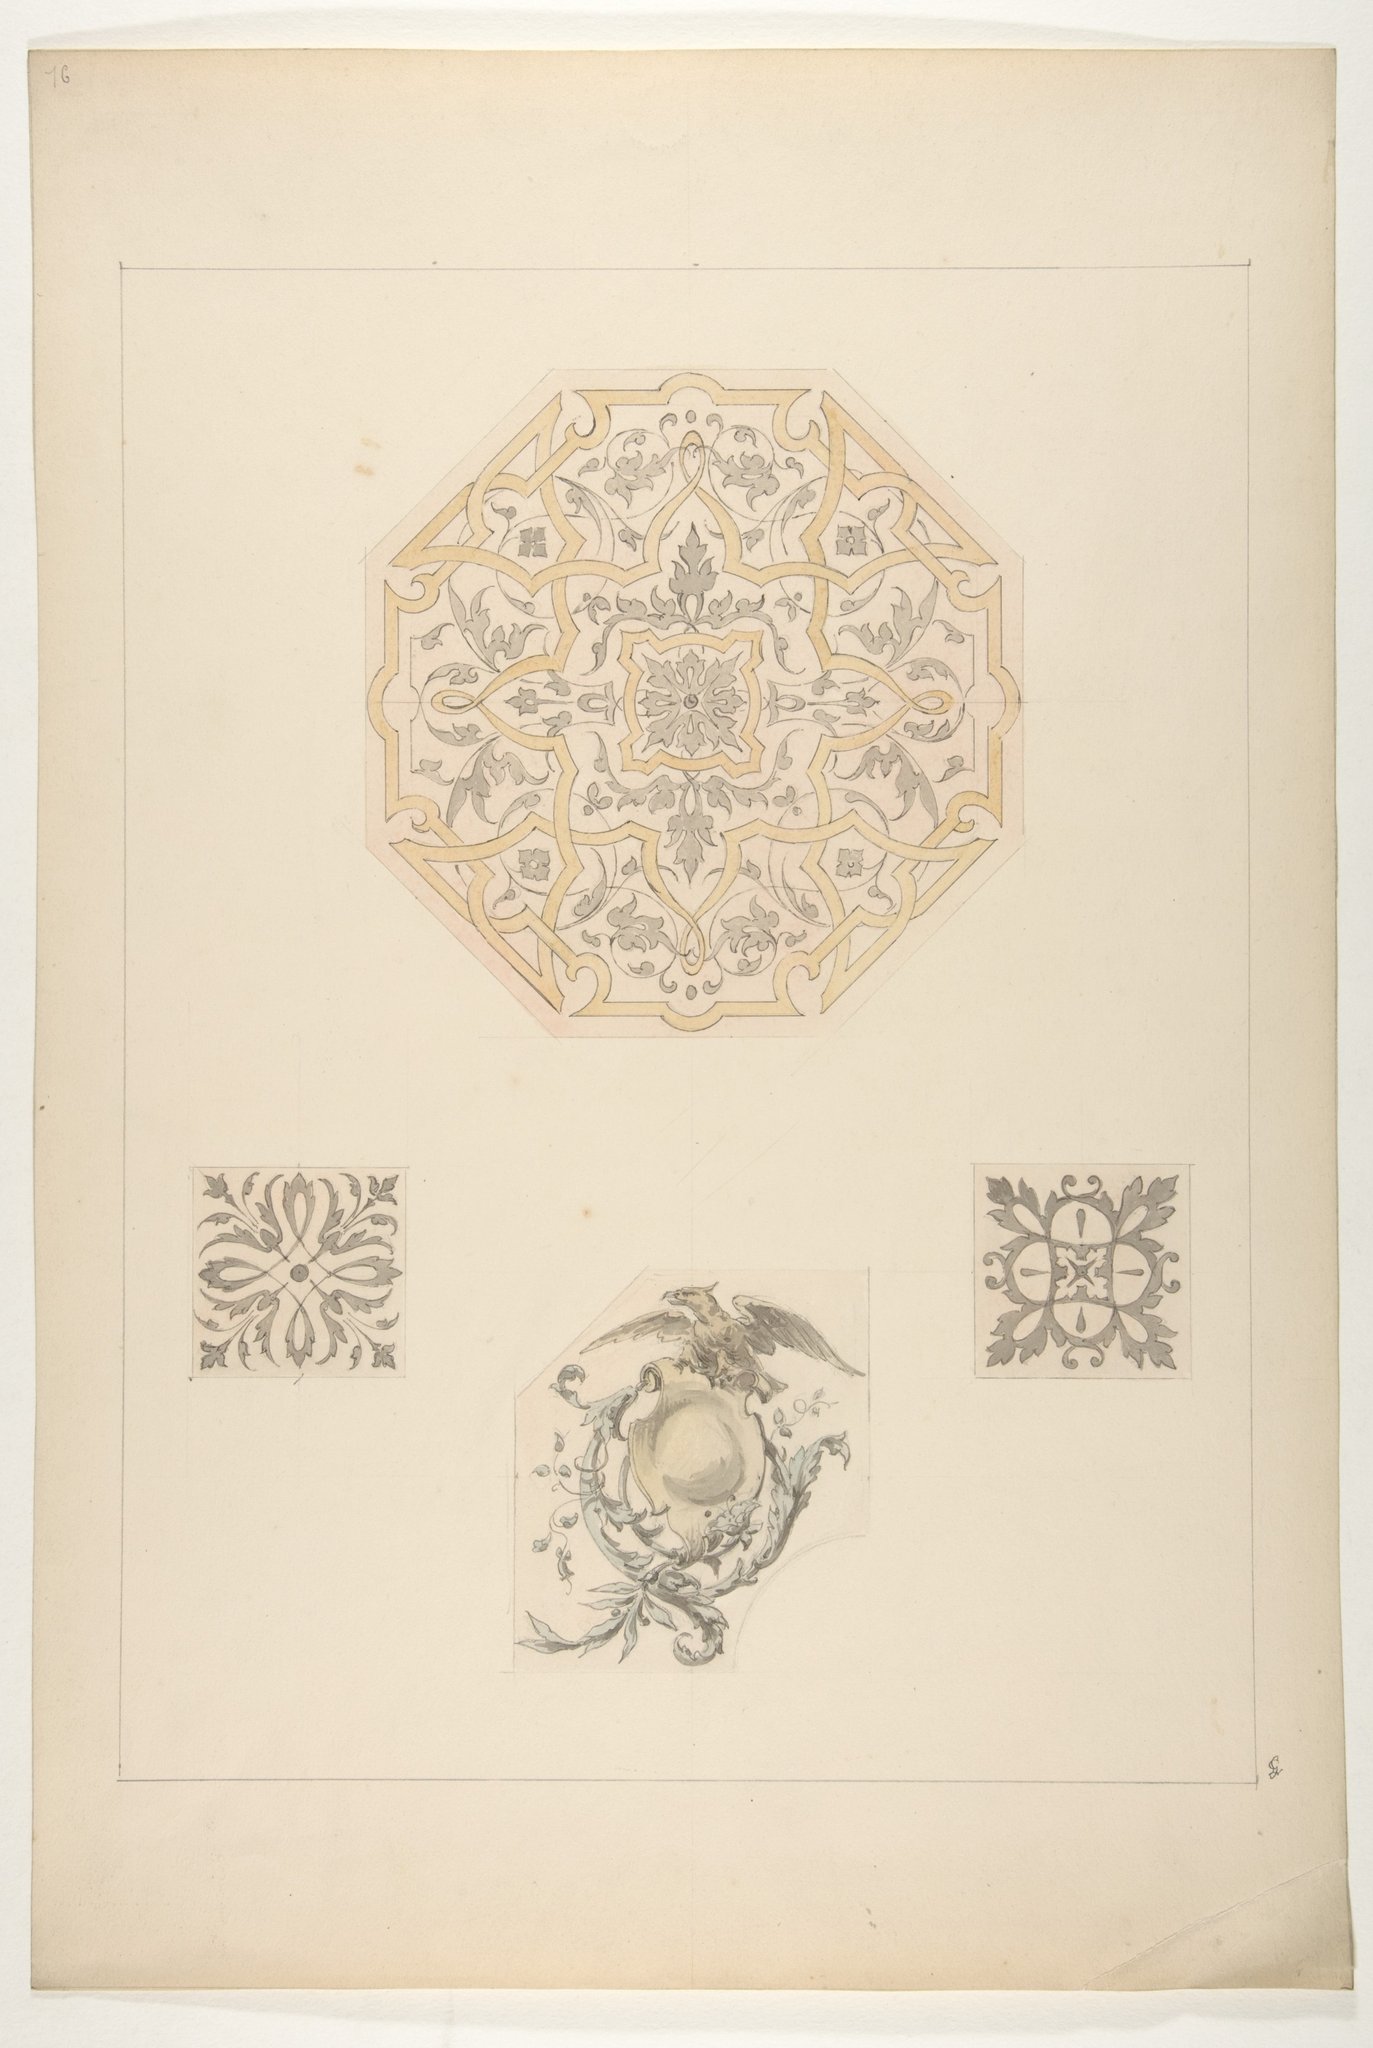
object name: drawing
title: Four designs for decorative motifs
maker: jules-edmond-charles lachaise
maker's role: artist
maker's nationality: french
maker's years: 1897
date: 1830-1897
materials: graphite, ink, watercolor, paper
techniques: pen, wash